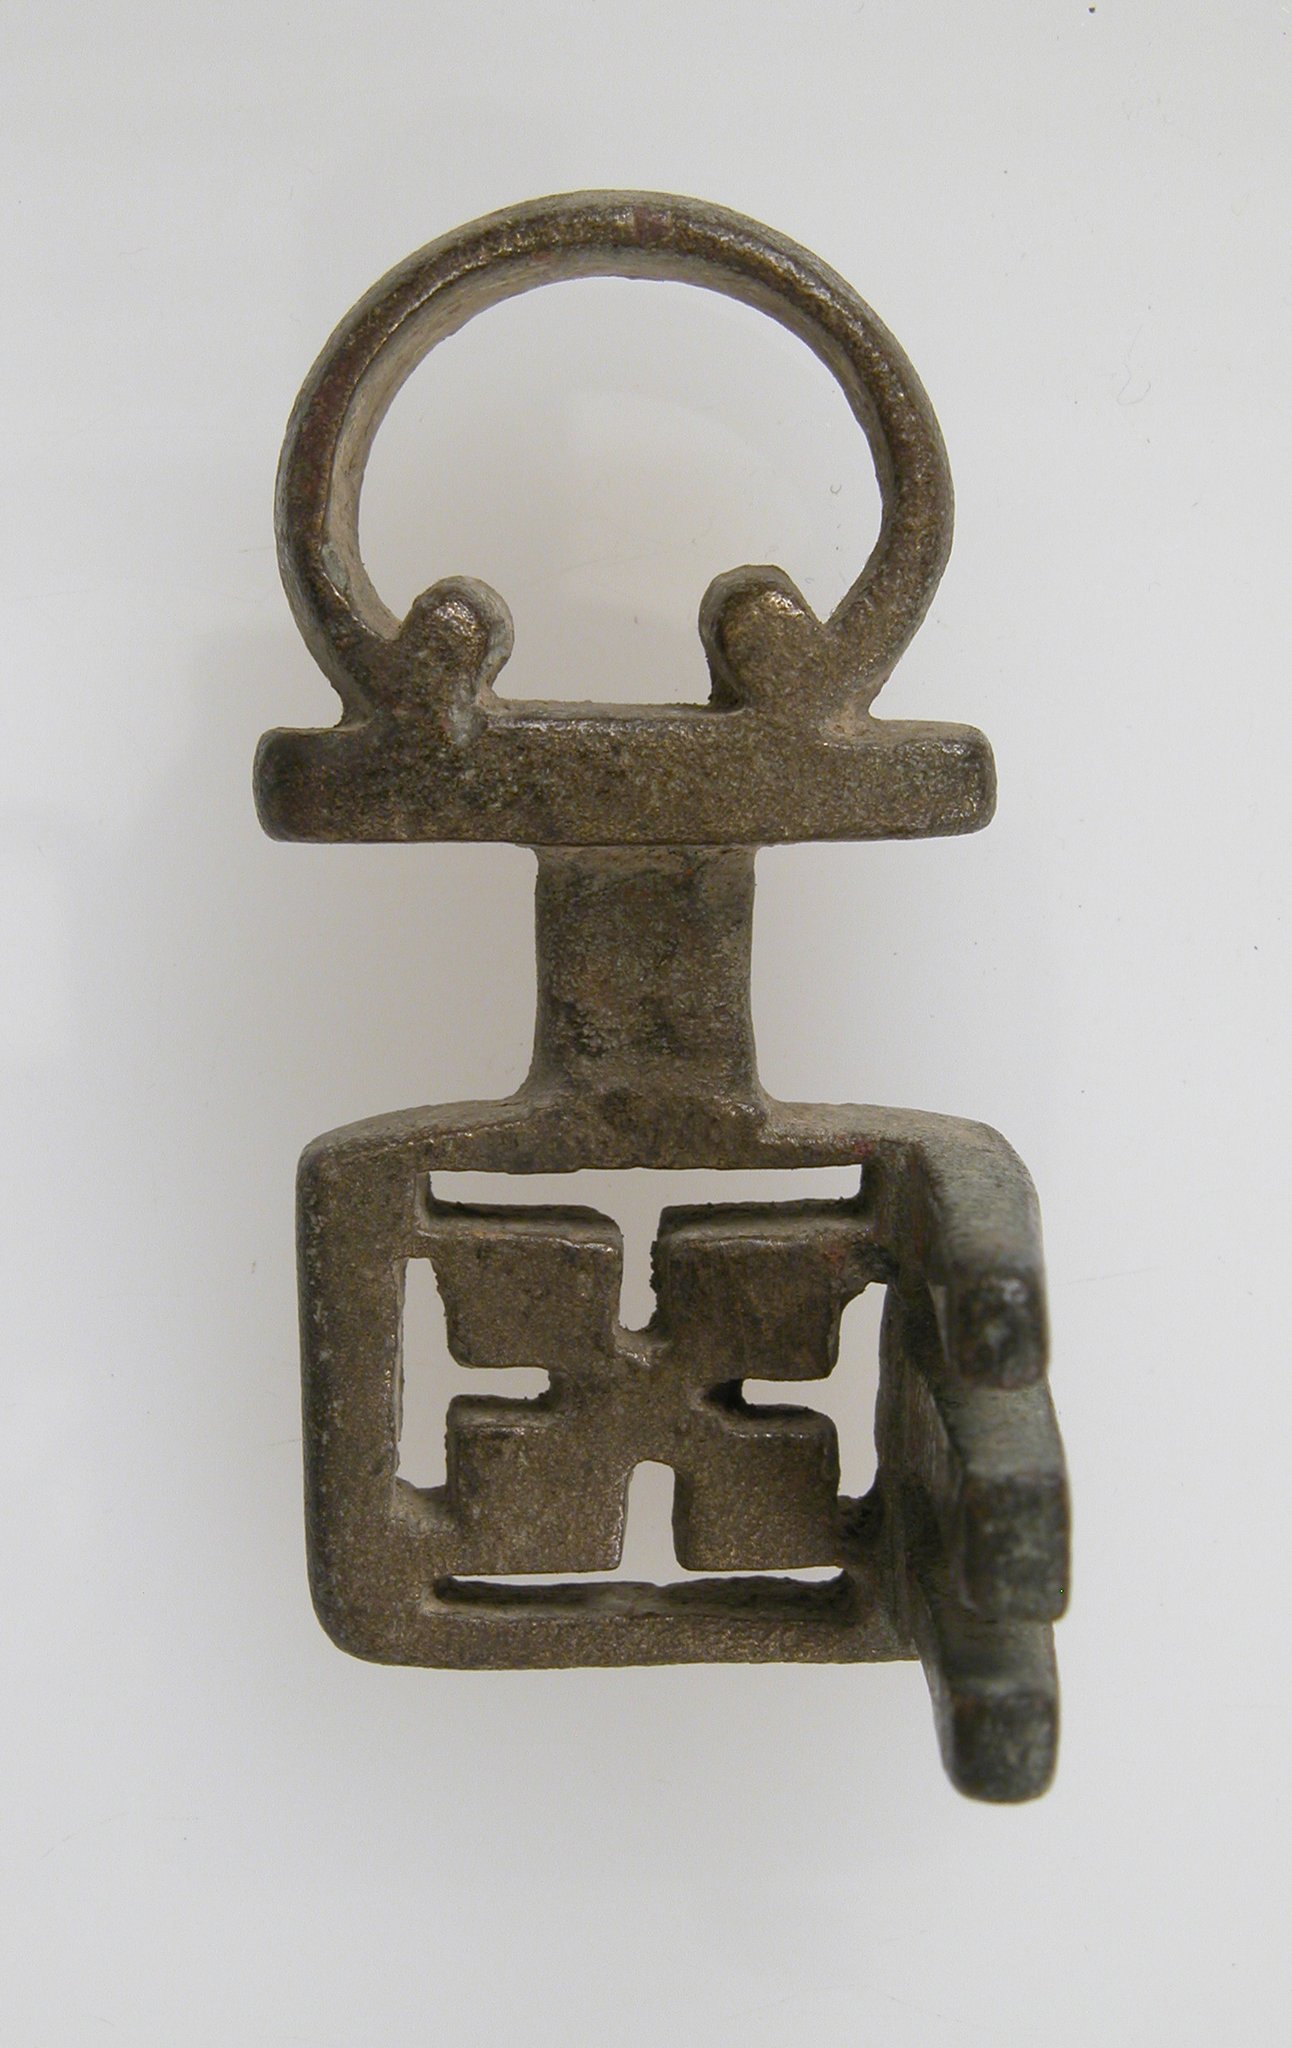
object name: key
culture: roman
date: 1-700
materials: copper alloy